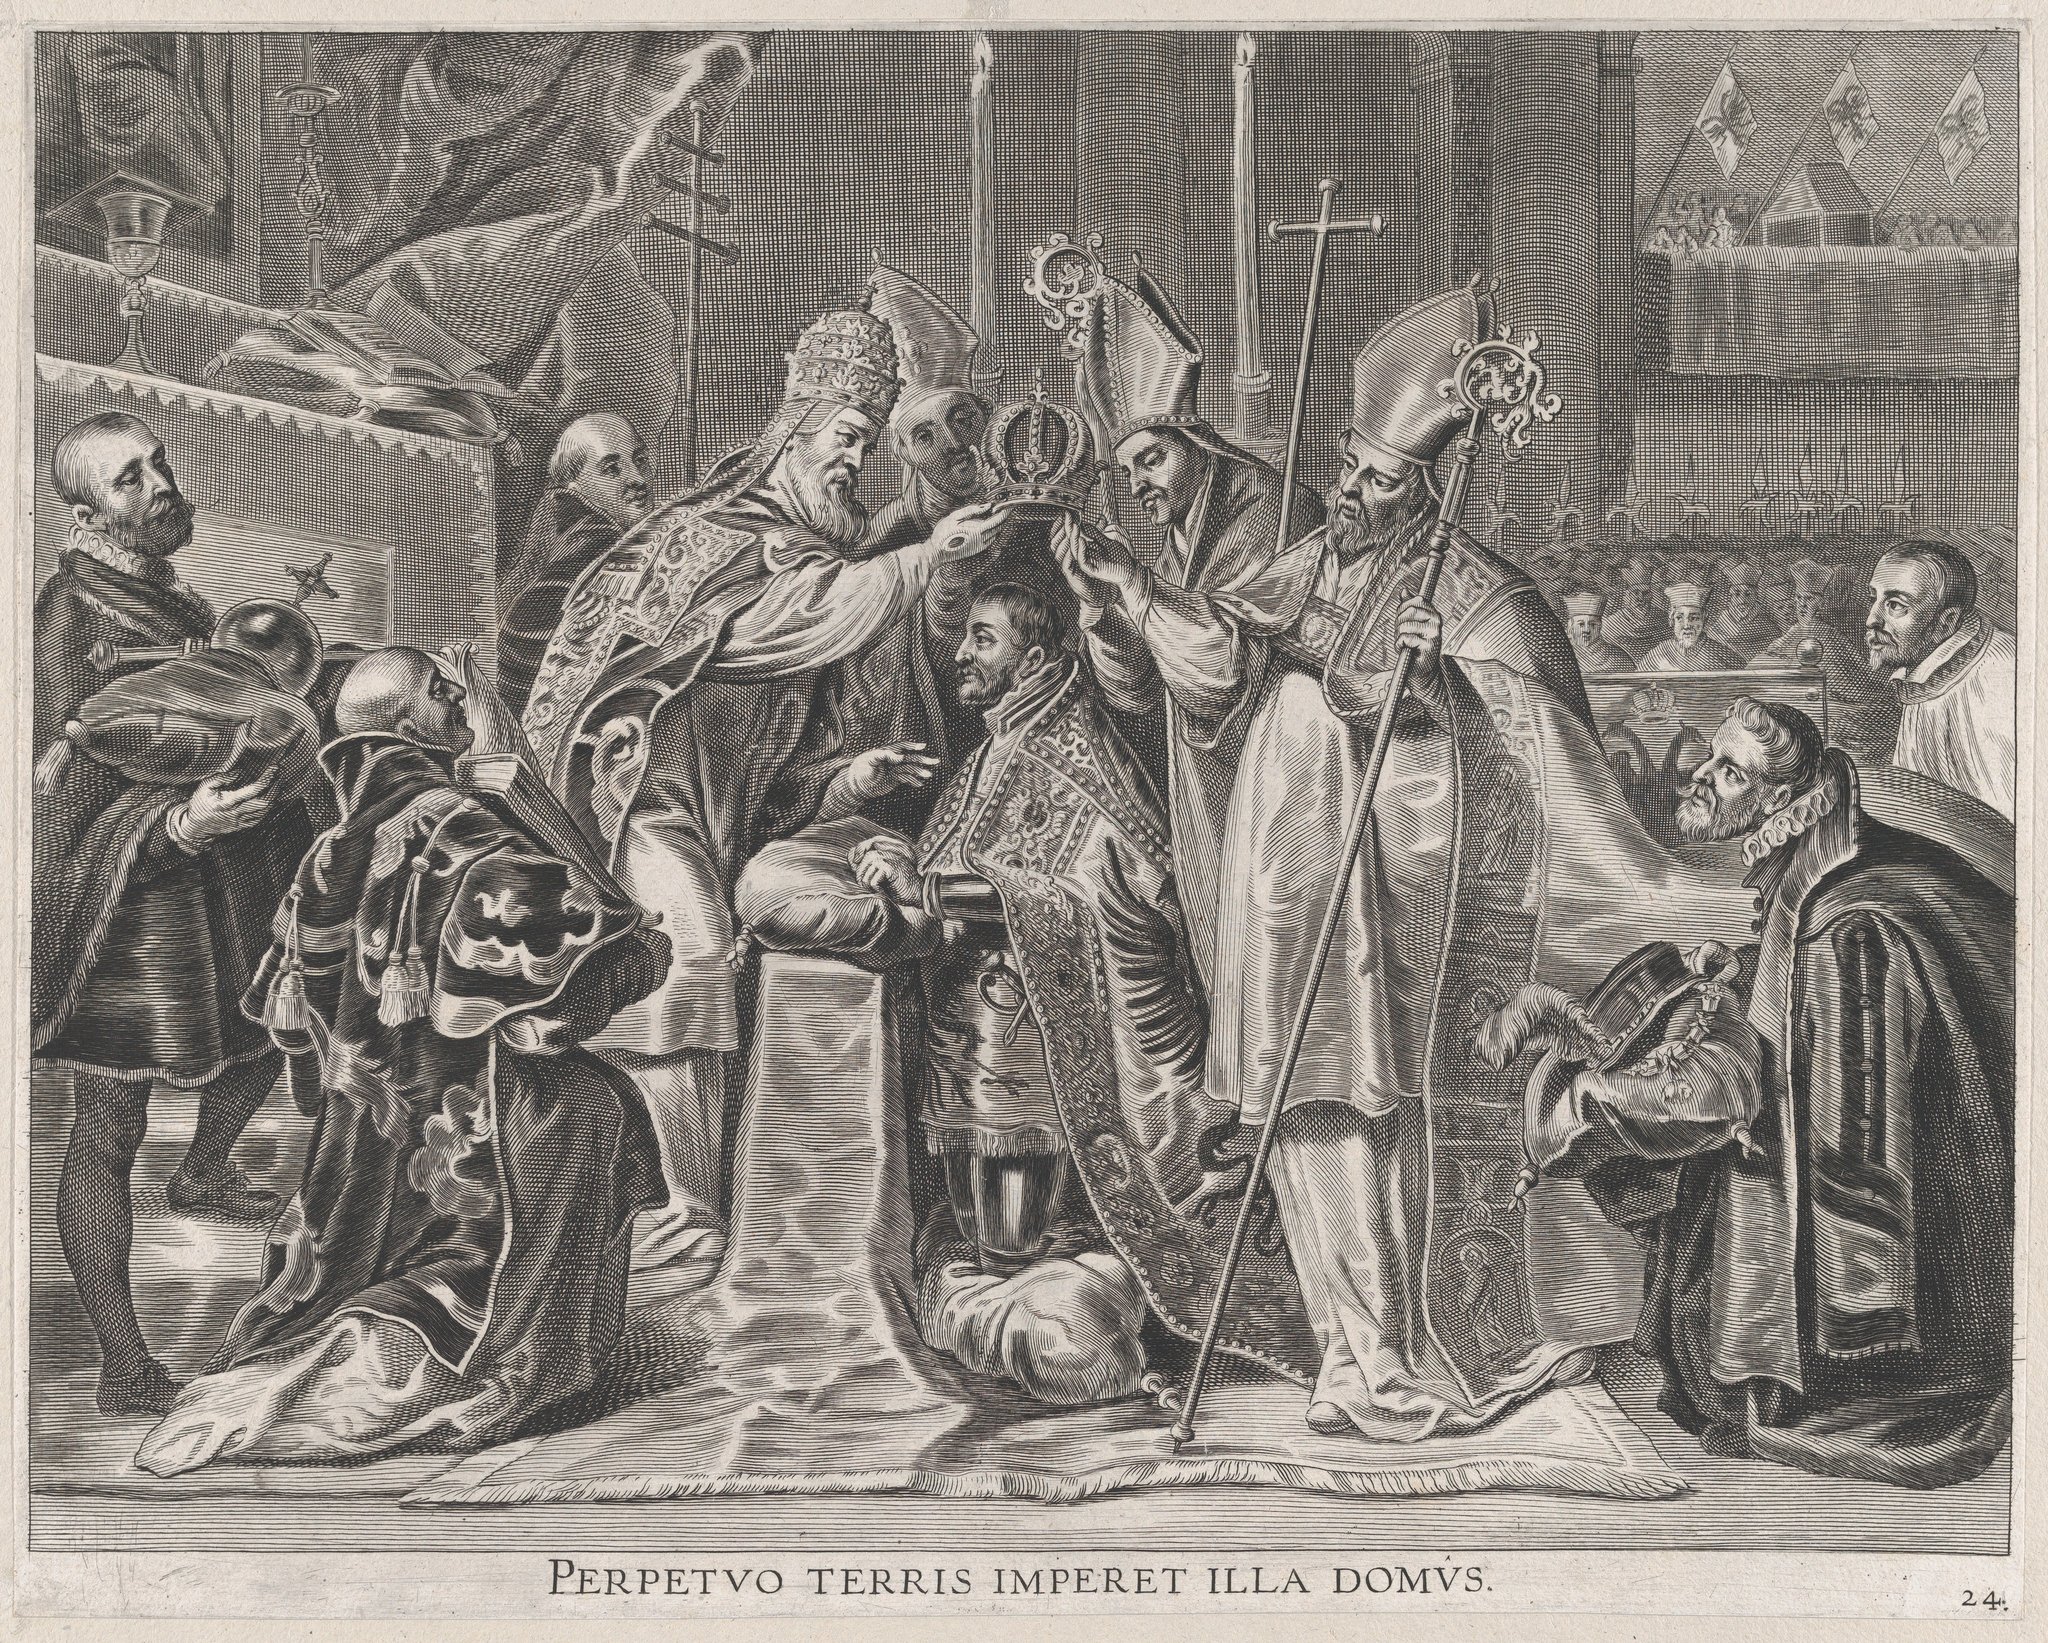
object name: print, fete, ornament architecture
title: Plate 24: Charles V crowned Emperor by the Pope; from Guillielmus Becanus's 'Serenissimi Principis Ferdinandi, Hispaniarum Infantis...'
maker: pieter de jode (ii)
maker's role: artist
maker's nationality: flemish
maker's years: 1606-1674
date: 1636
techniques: engraving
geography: antwerp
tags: men,popes,cross,croziers